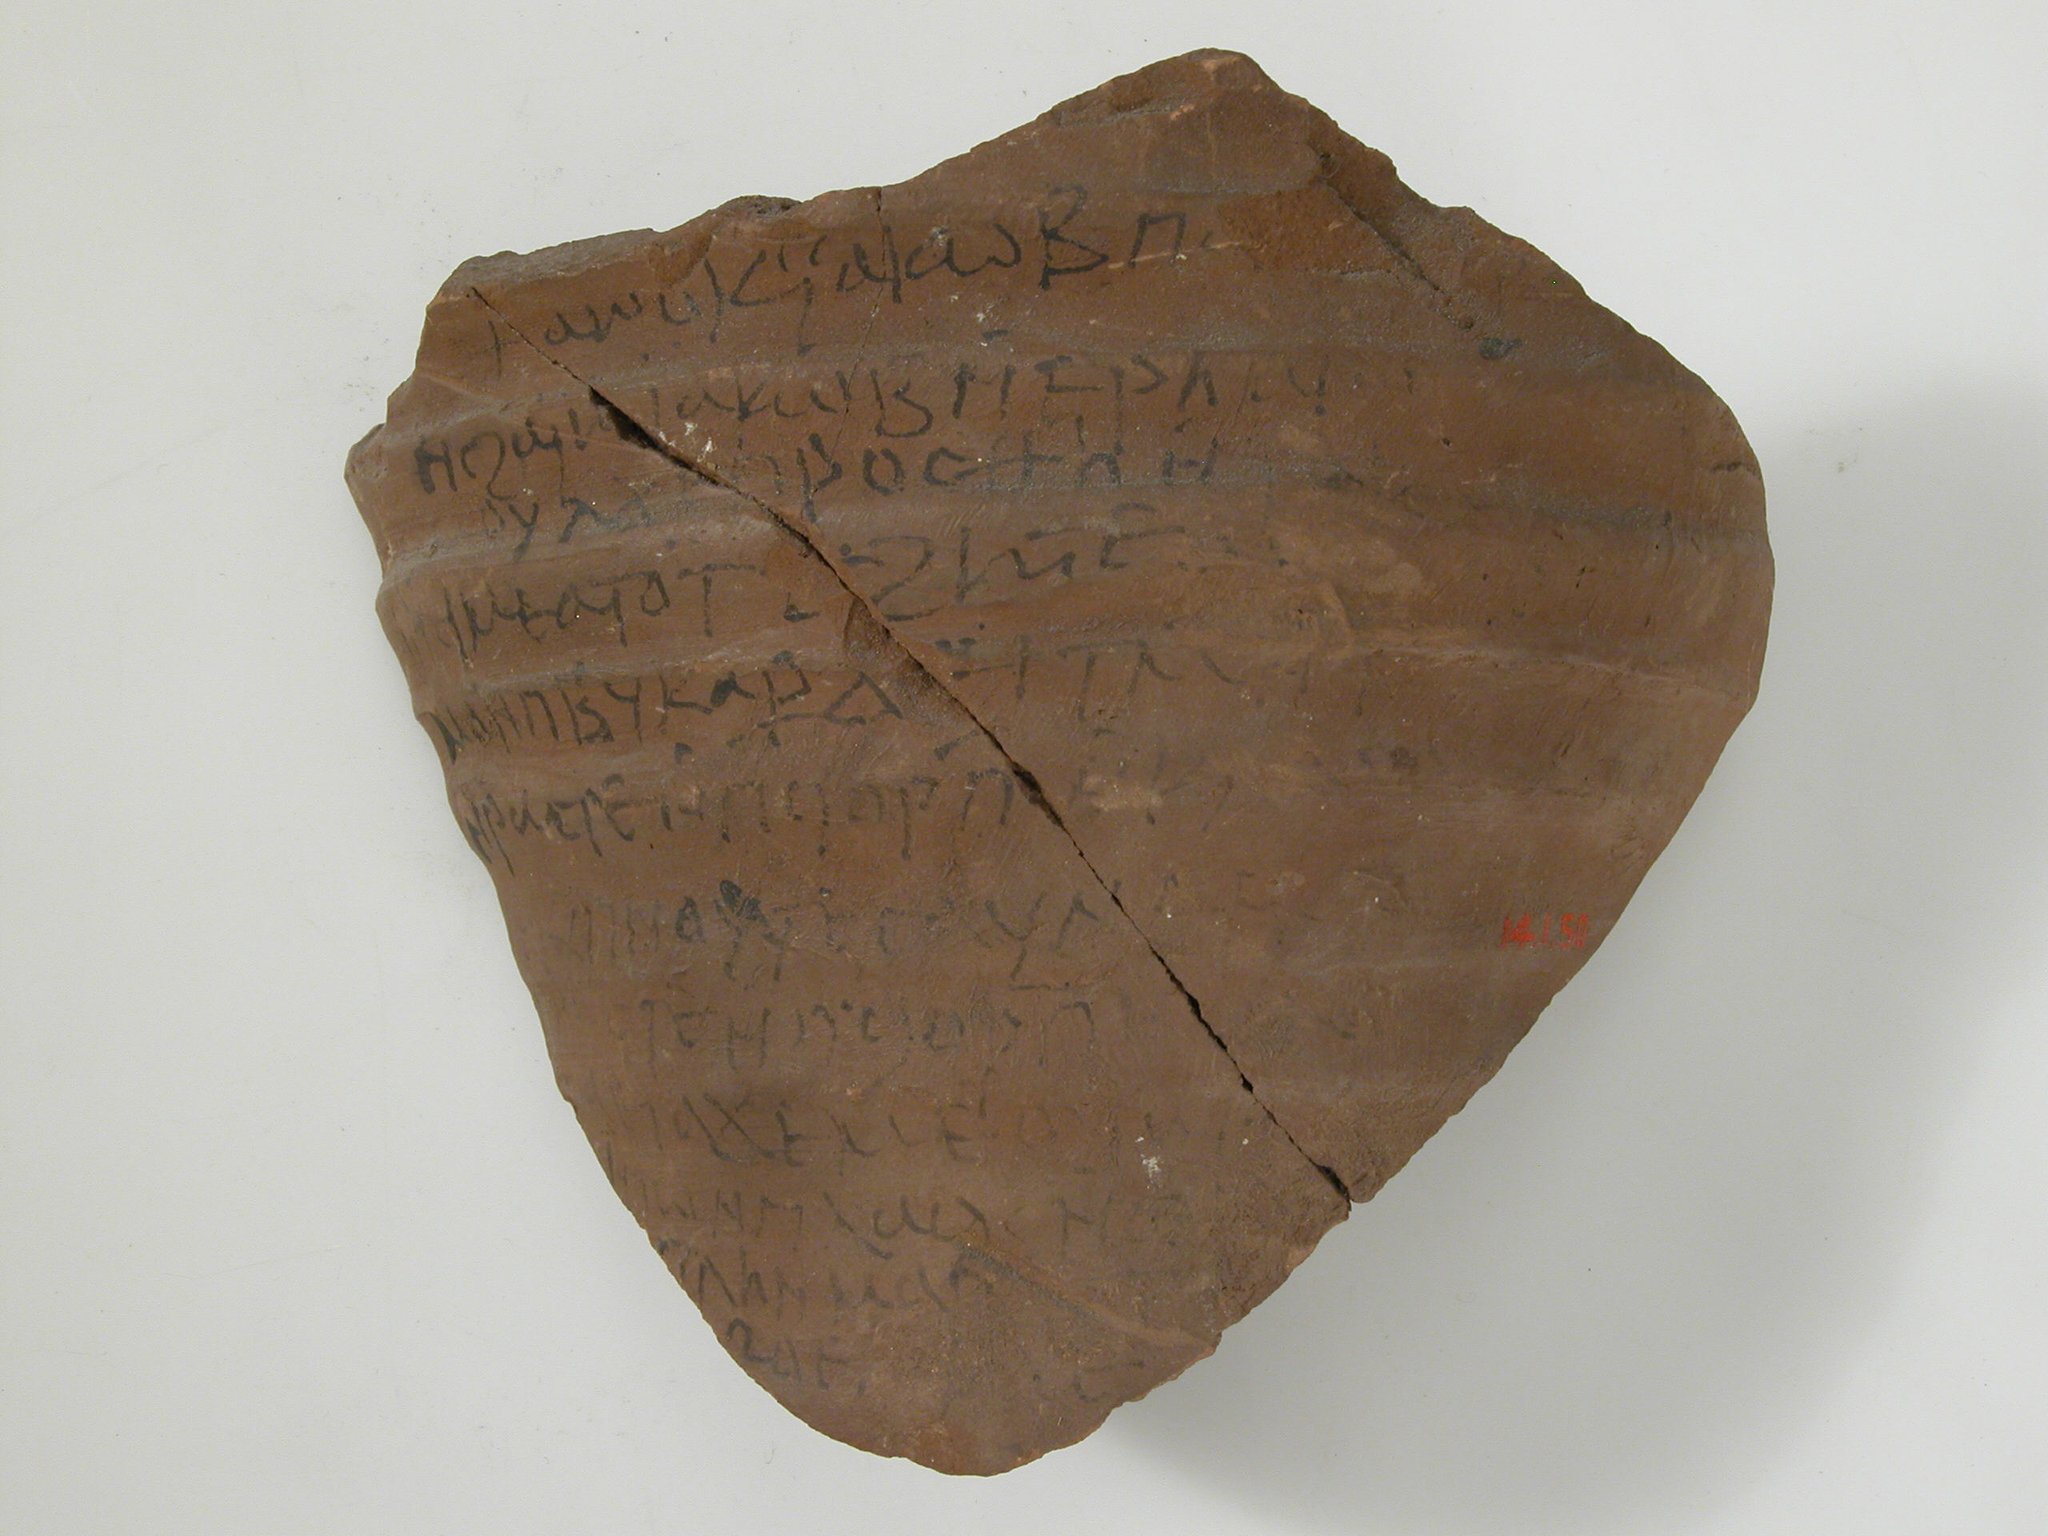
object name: ostrakon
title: Ostrakon with a Letter from Jacob to Jacob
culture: coptic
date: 600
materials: ink, pottery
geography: egypt